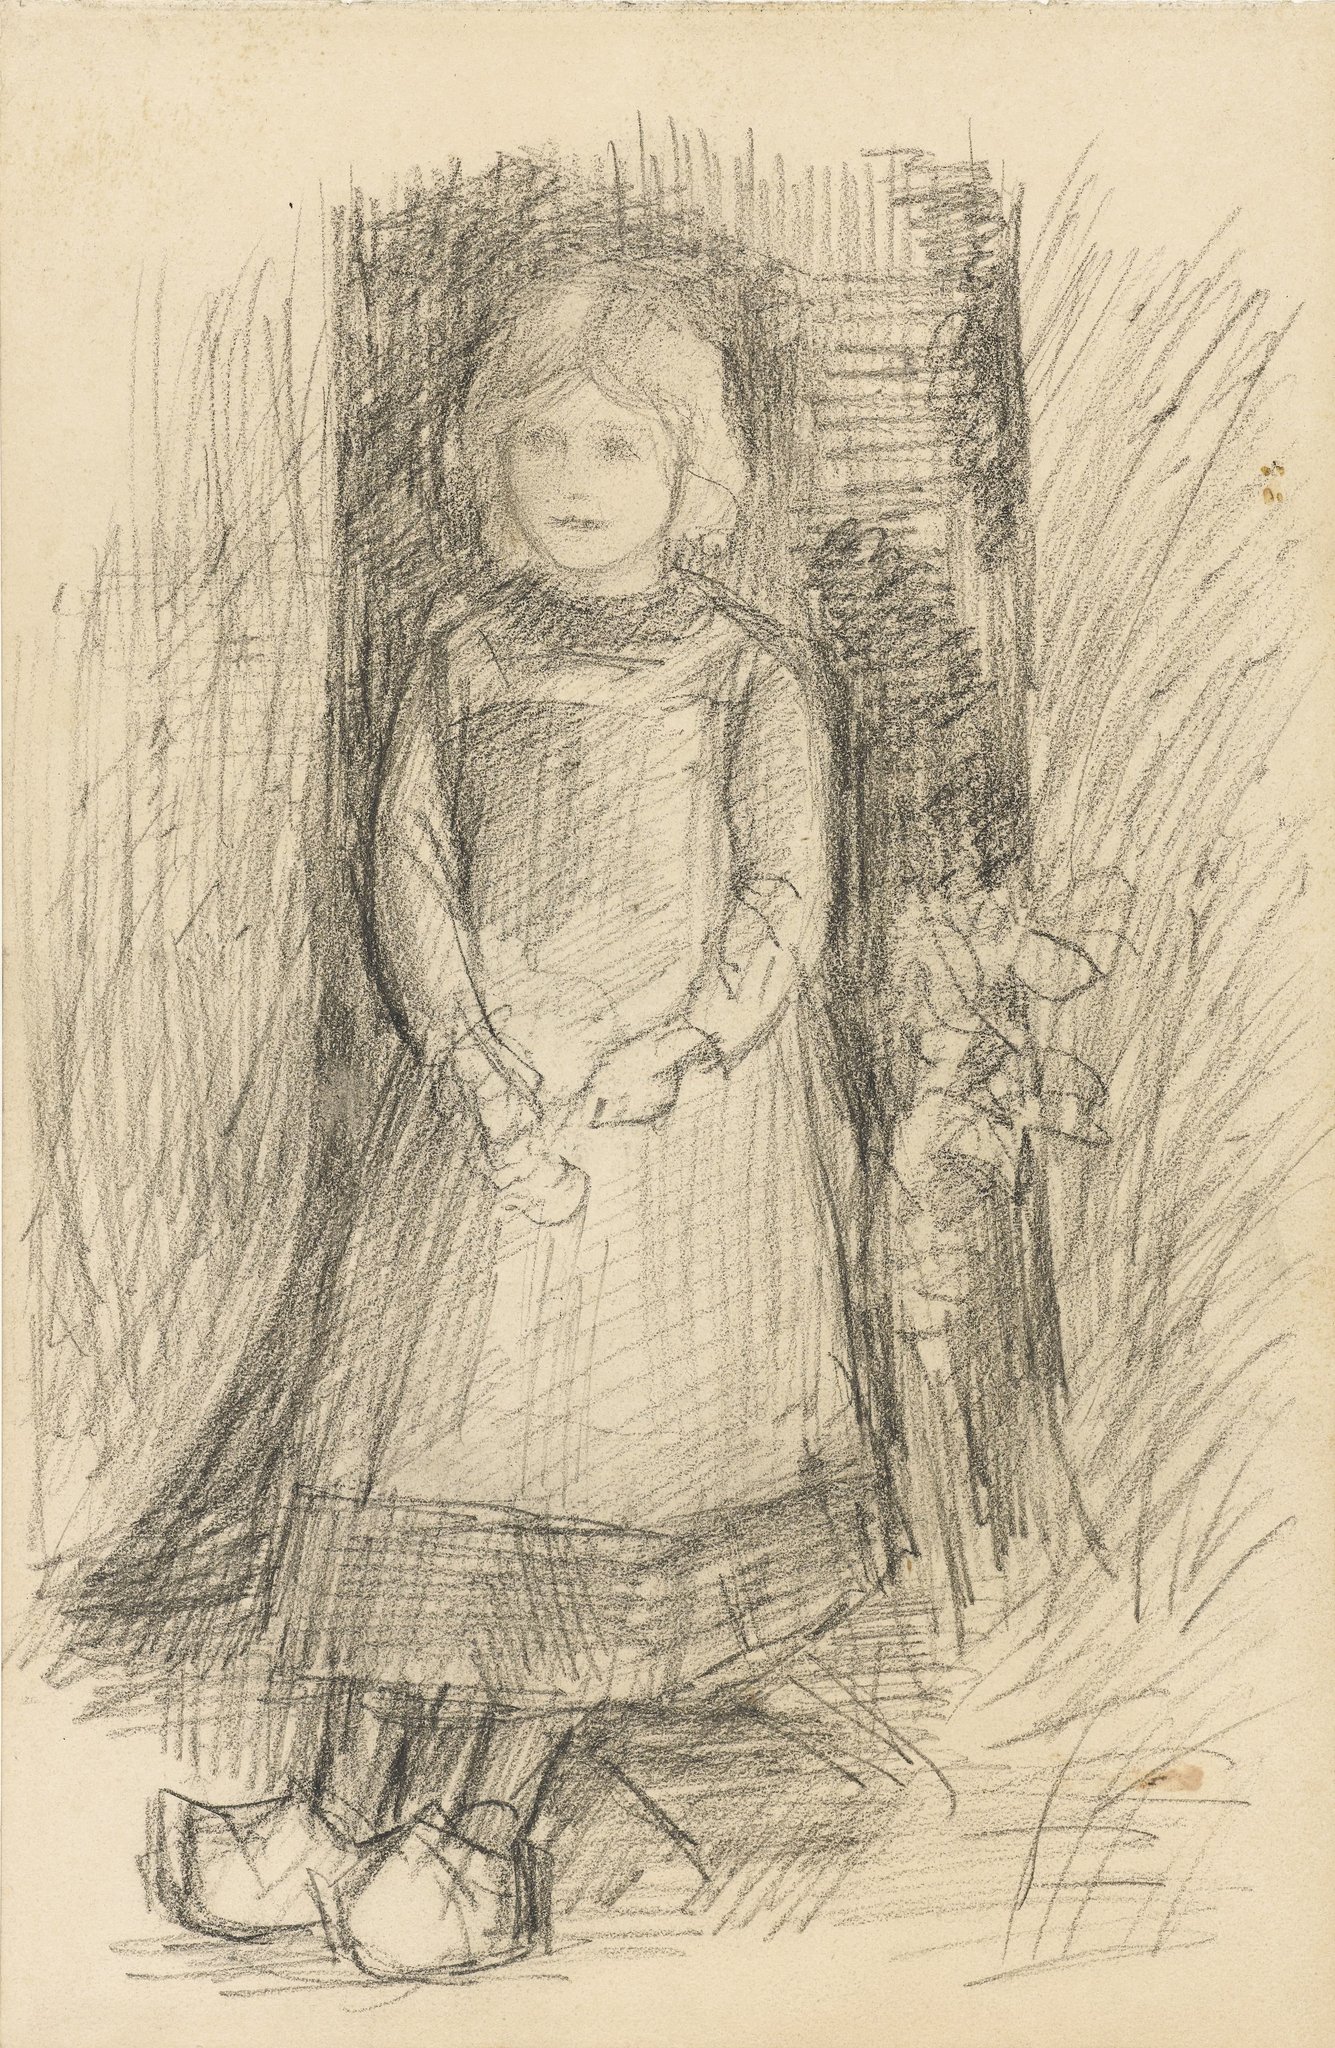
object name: drawing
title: Meisje leunend tegen een boom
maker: jozef israëls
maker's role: draughtsman, painter, print maker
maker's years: 1824-1911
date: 1834-1911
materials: chalk, paper